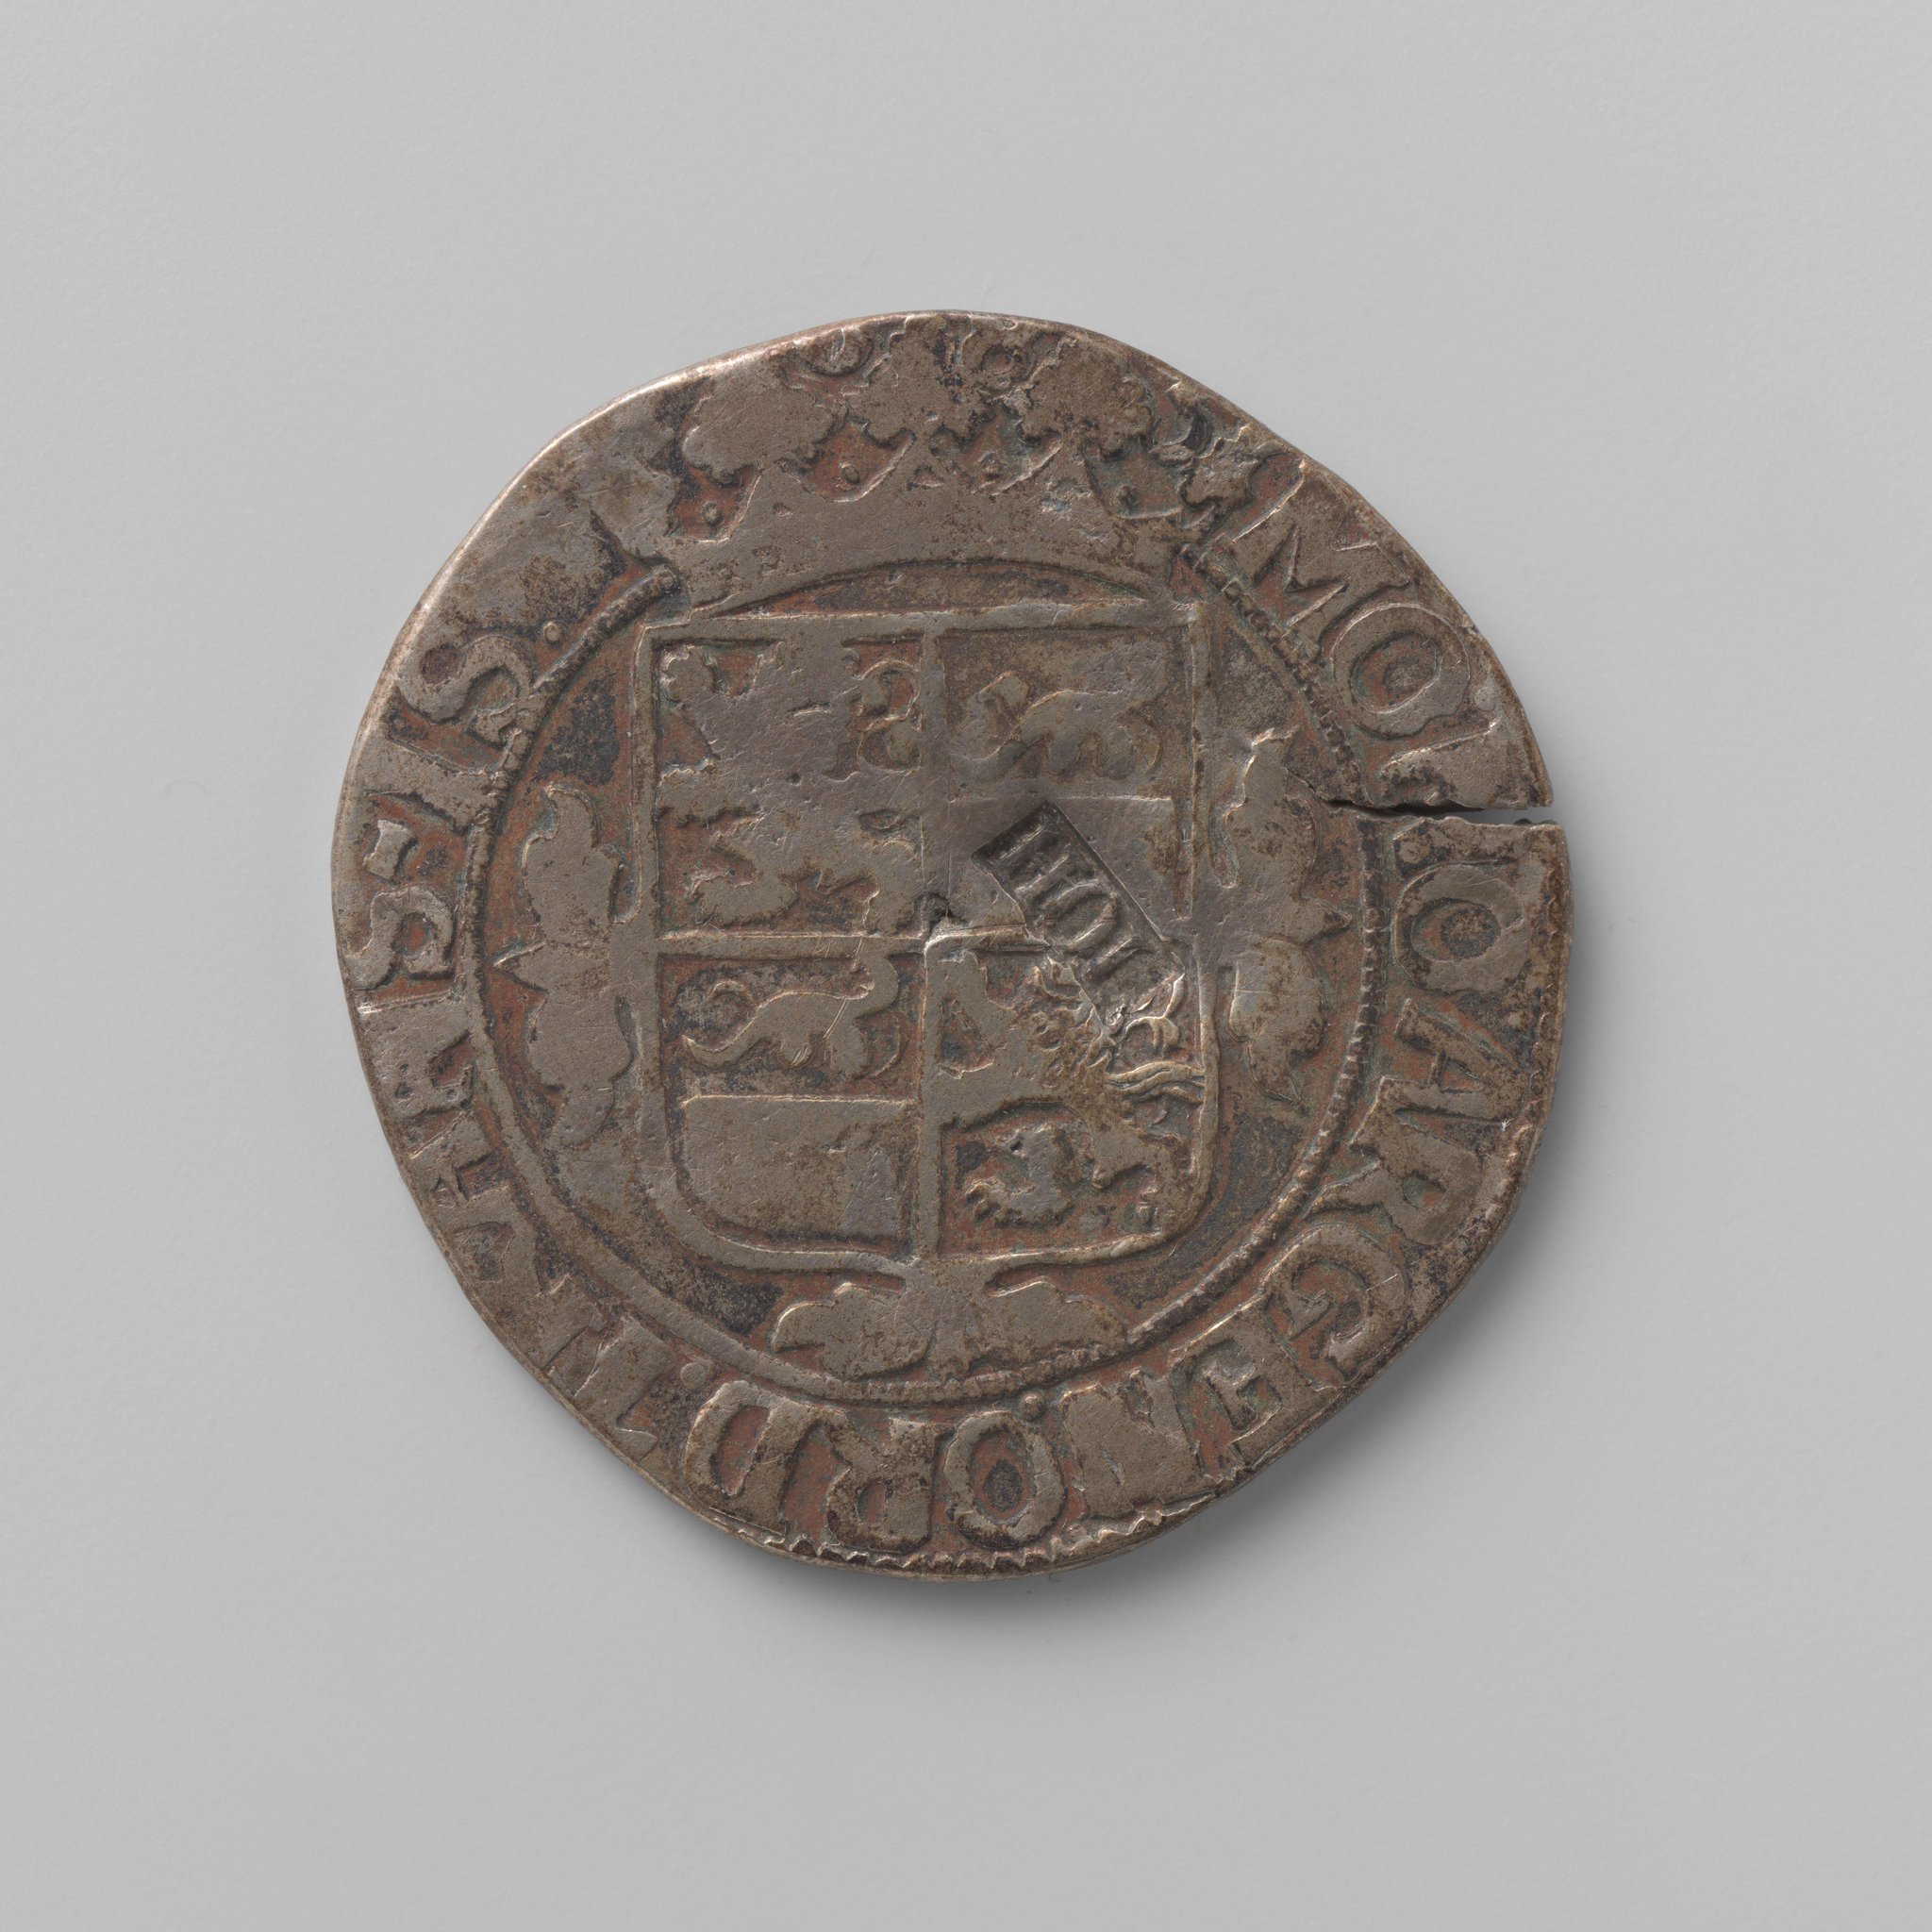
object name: coin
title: Overijsselse florijn van 28 stuiver, 1685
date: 1685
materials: silver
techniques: striking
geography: kampen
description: Zilveren munt. Voorzijde: op kort bloemenkruis gekroond gevierendeeld wapenschild. Jaartal boven kroon. Keerzijde: dubbelkoppige adelaar met op borrst waarde-aanduiding 28. Op voorzijde klop HOL .